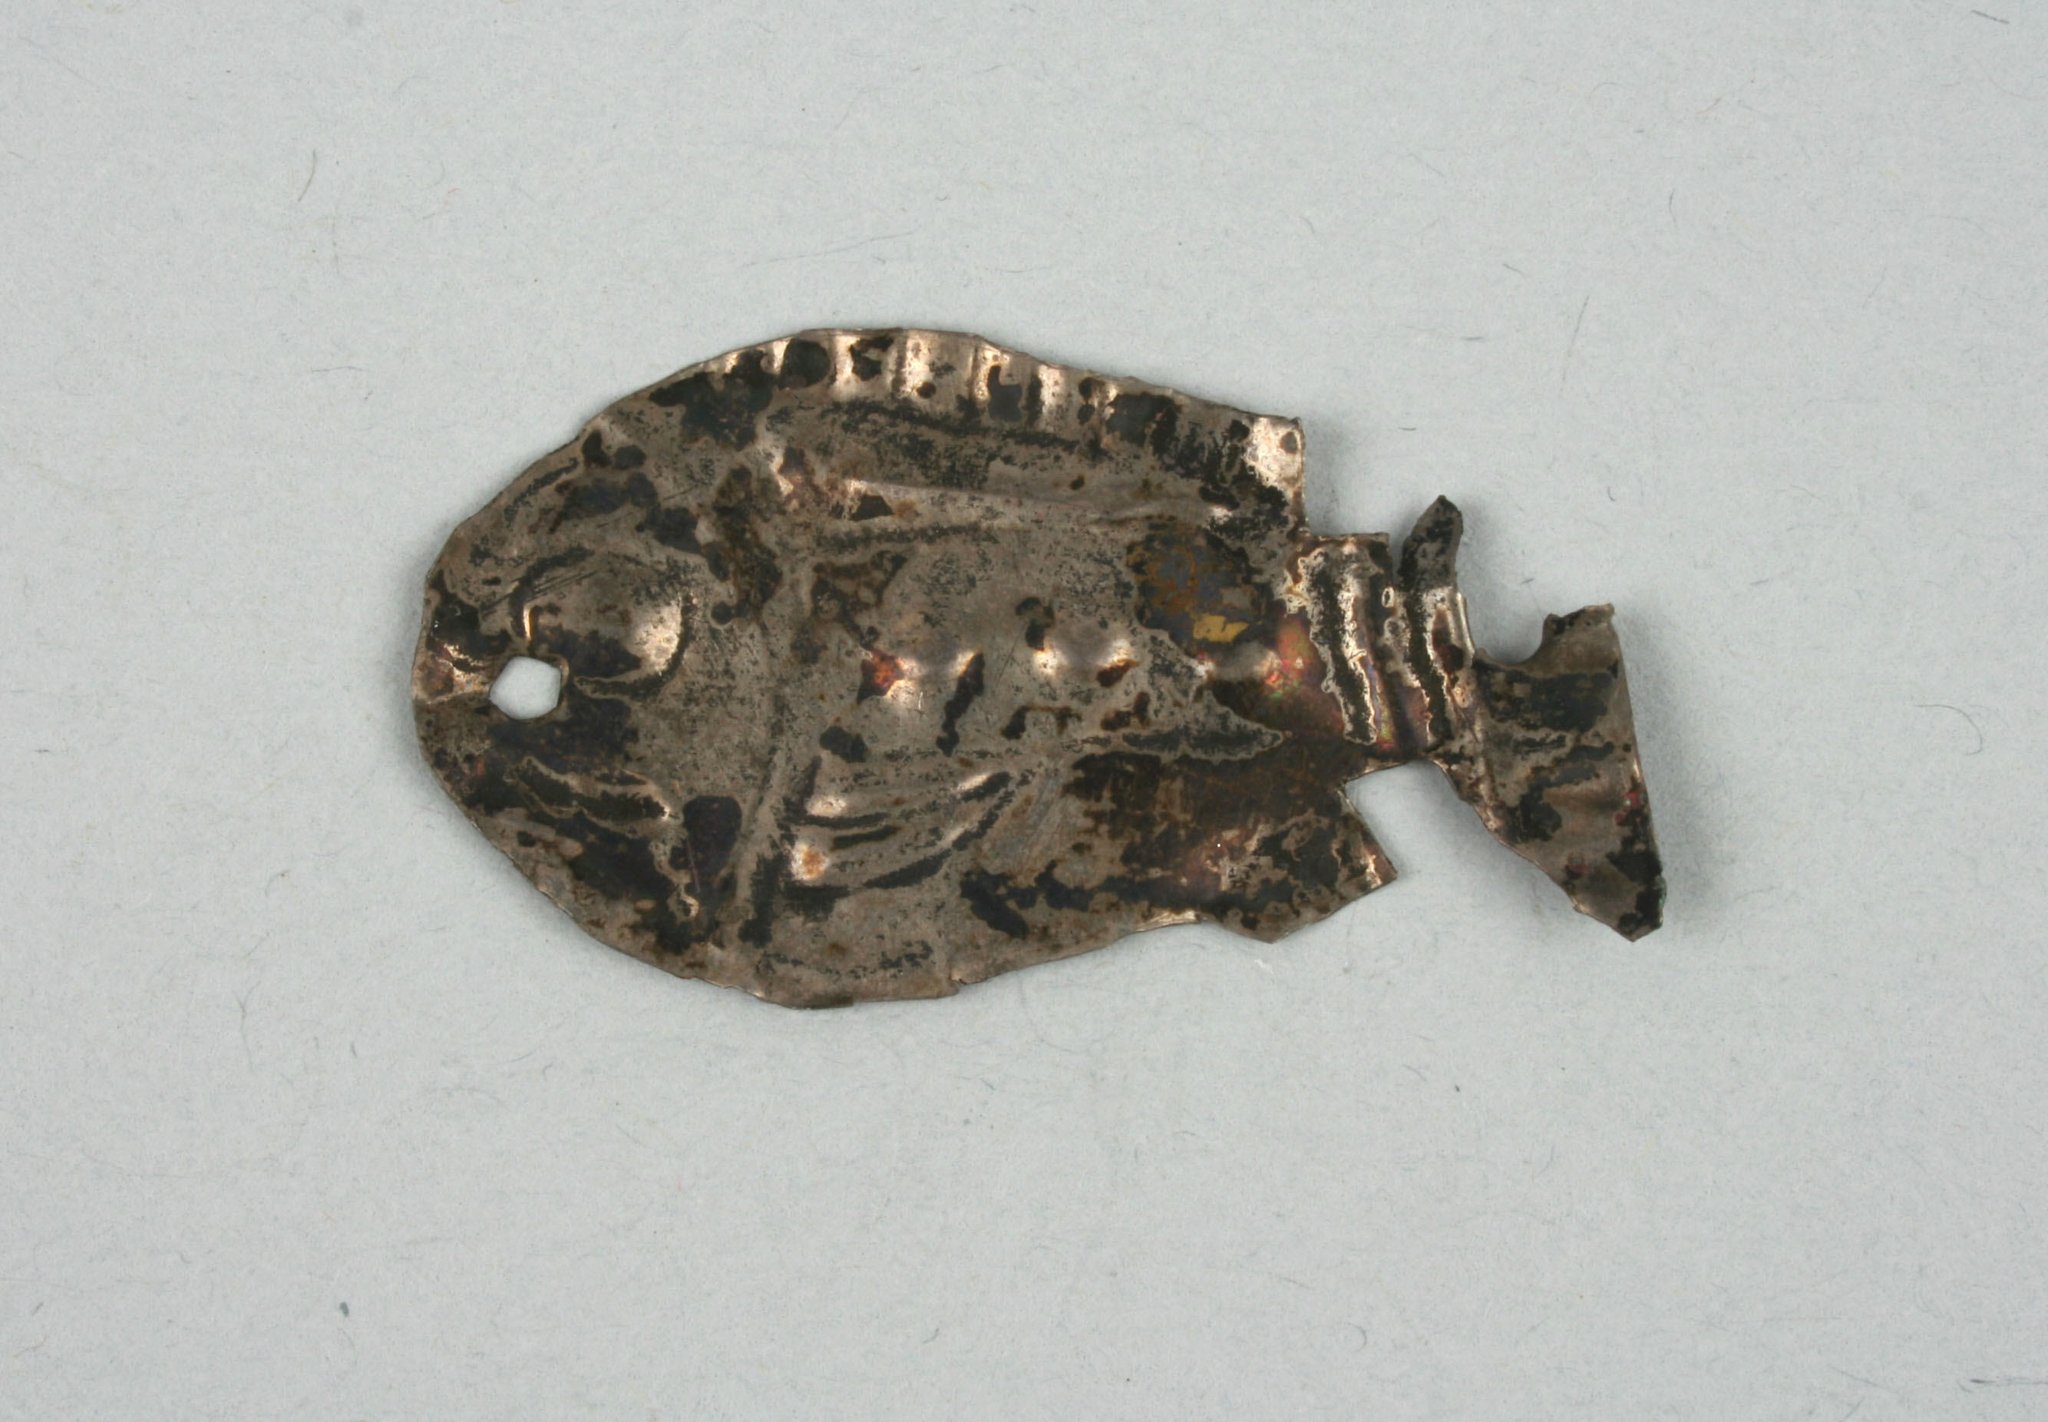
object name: costume ornament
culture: peruvian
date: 1001-1200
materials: silver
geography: peru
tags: fish